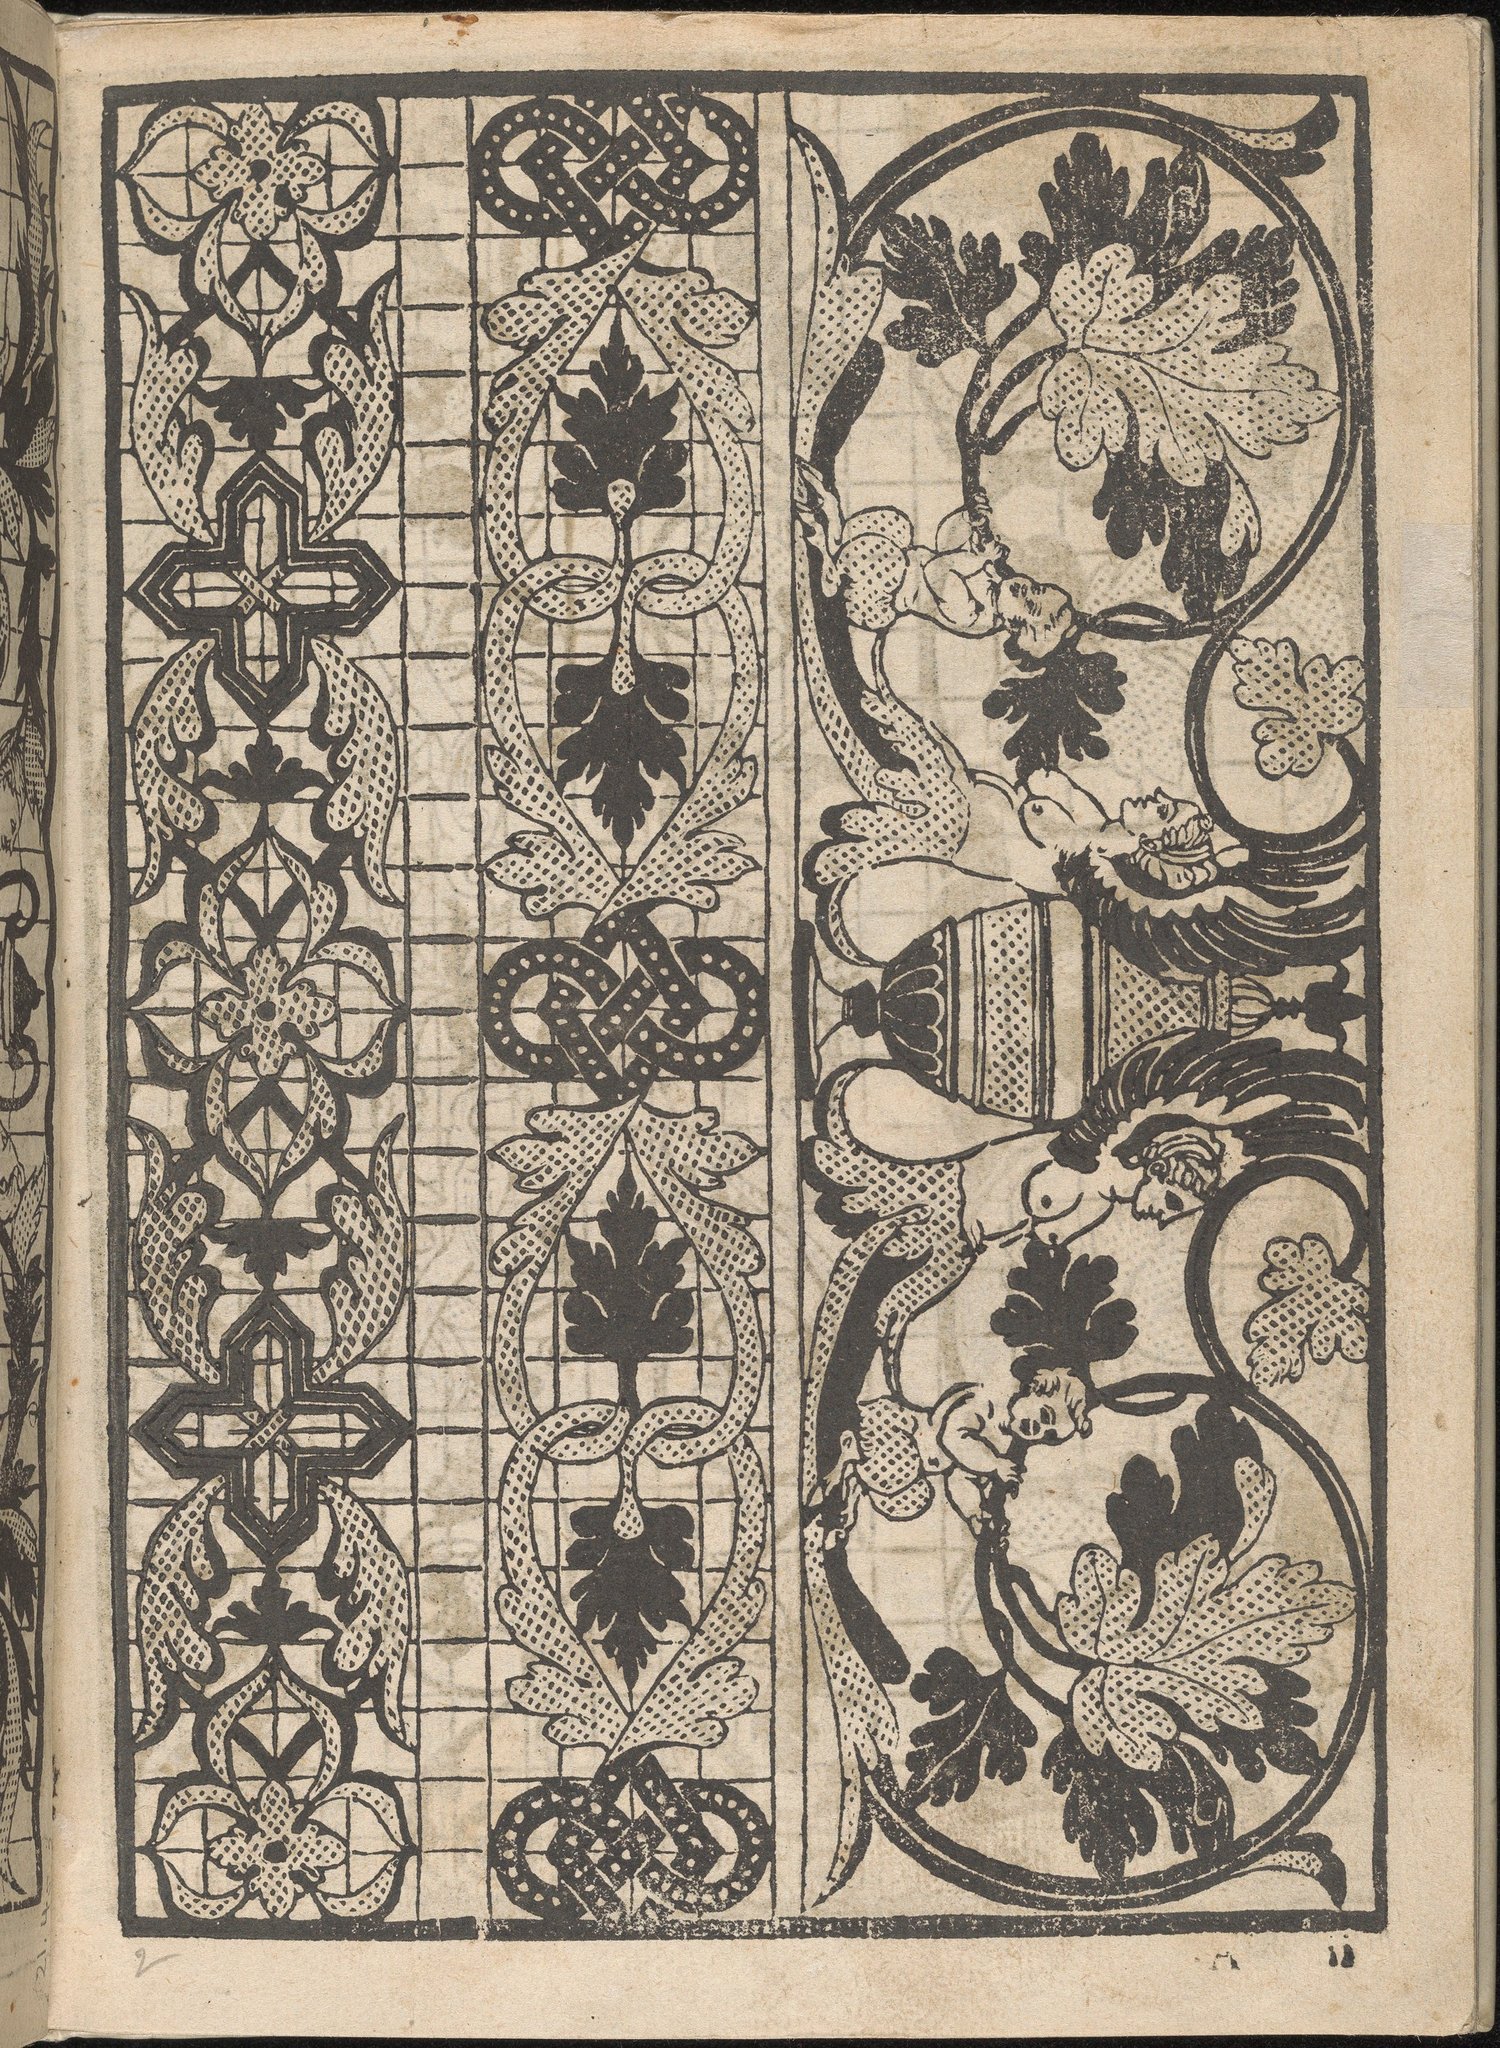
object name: book print ornament architecture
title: Splendore delle virtuose giovani, title page (verso)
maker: iseppo foresto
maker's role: designer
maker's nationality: italian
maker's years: 1520-1580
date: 1564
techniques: woodcut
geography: italy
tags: ornament,leaves